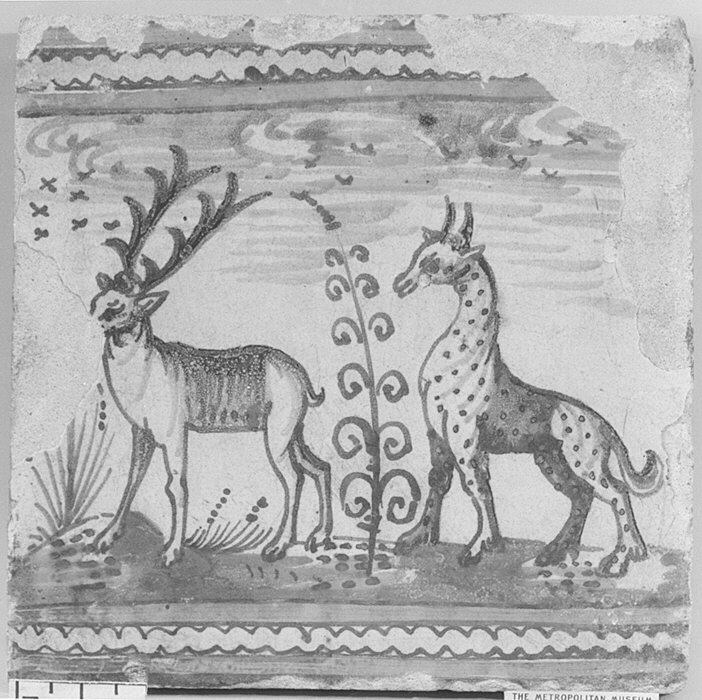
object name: tile from a frieze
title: Frieze tile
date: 1600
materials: earthenware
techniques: glazing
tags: deer,giraffes